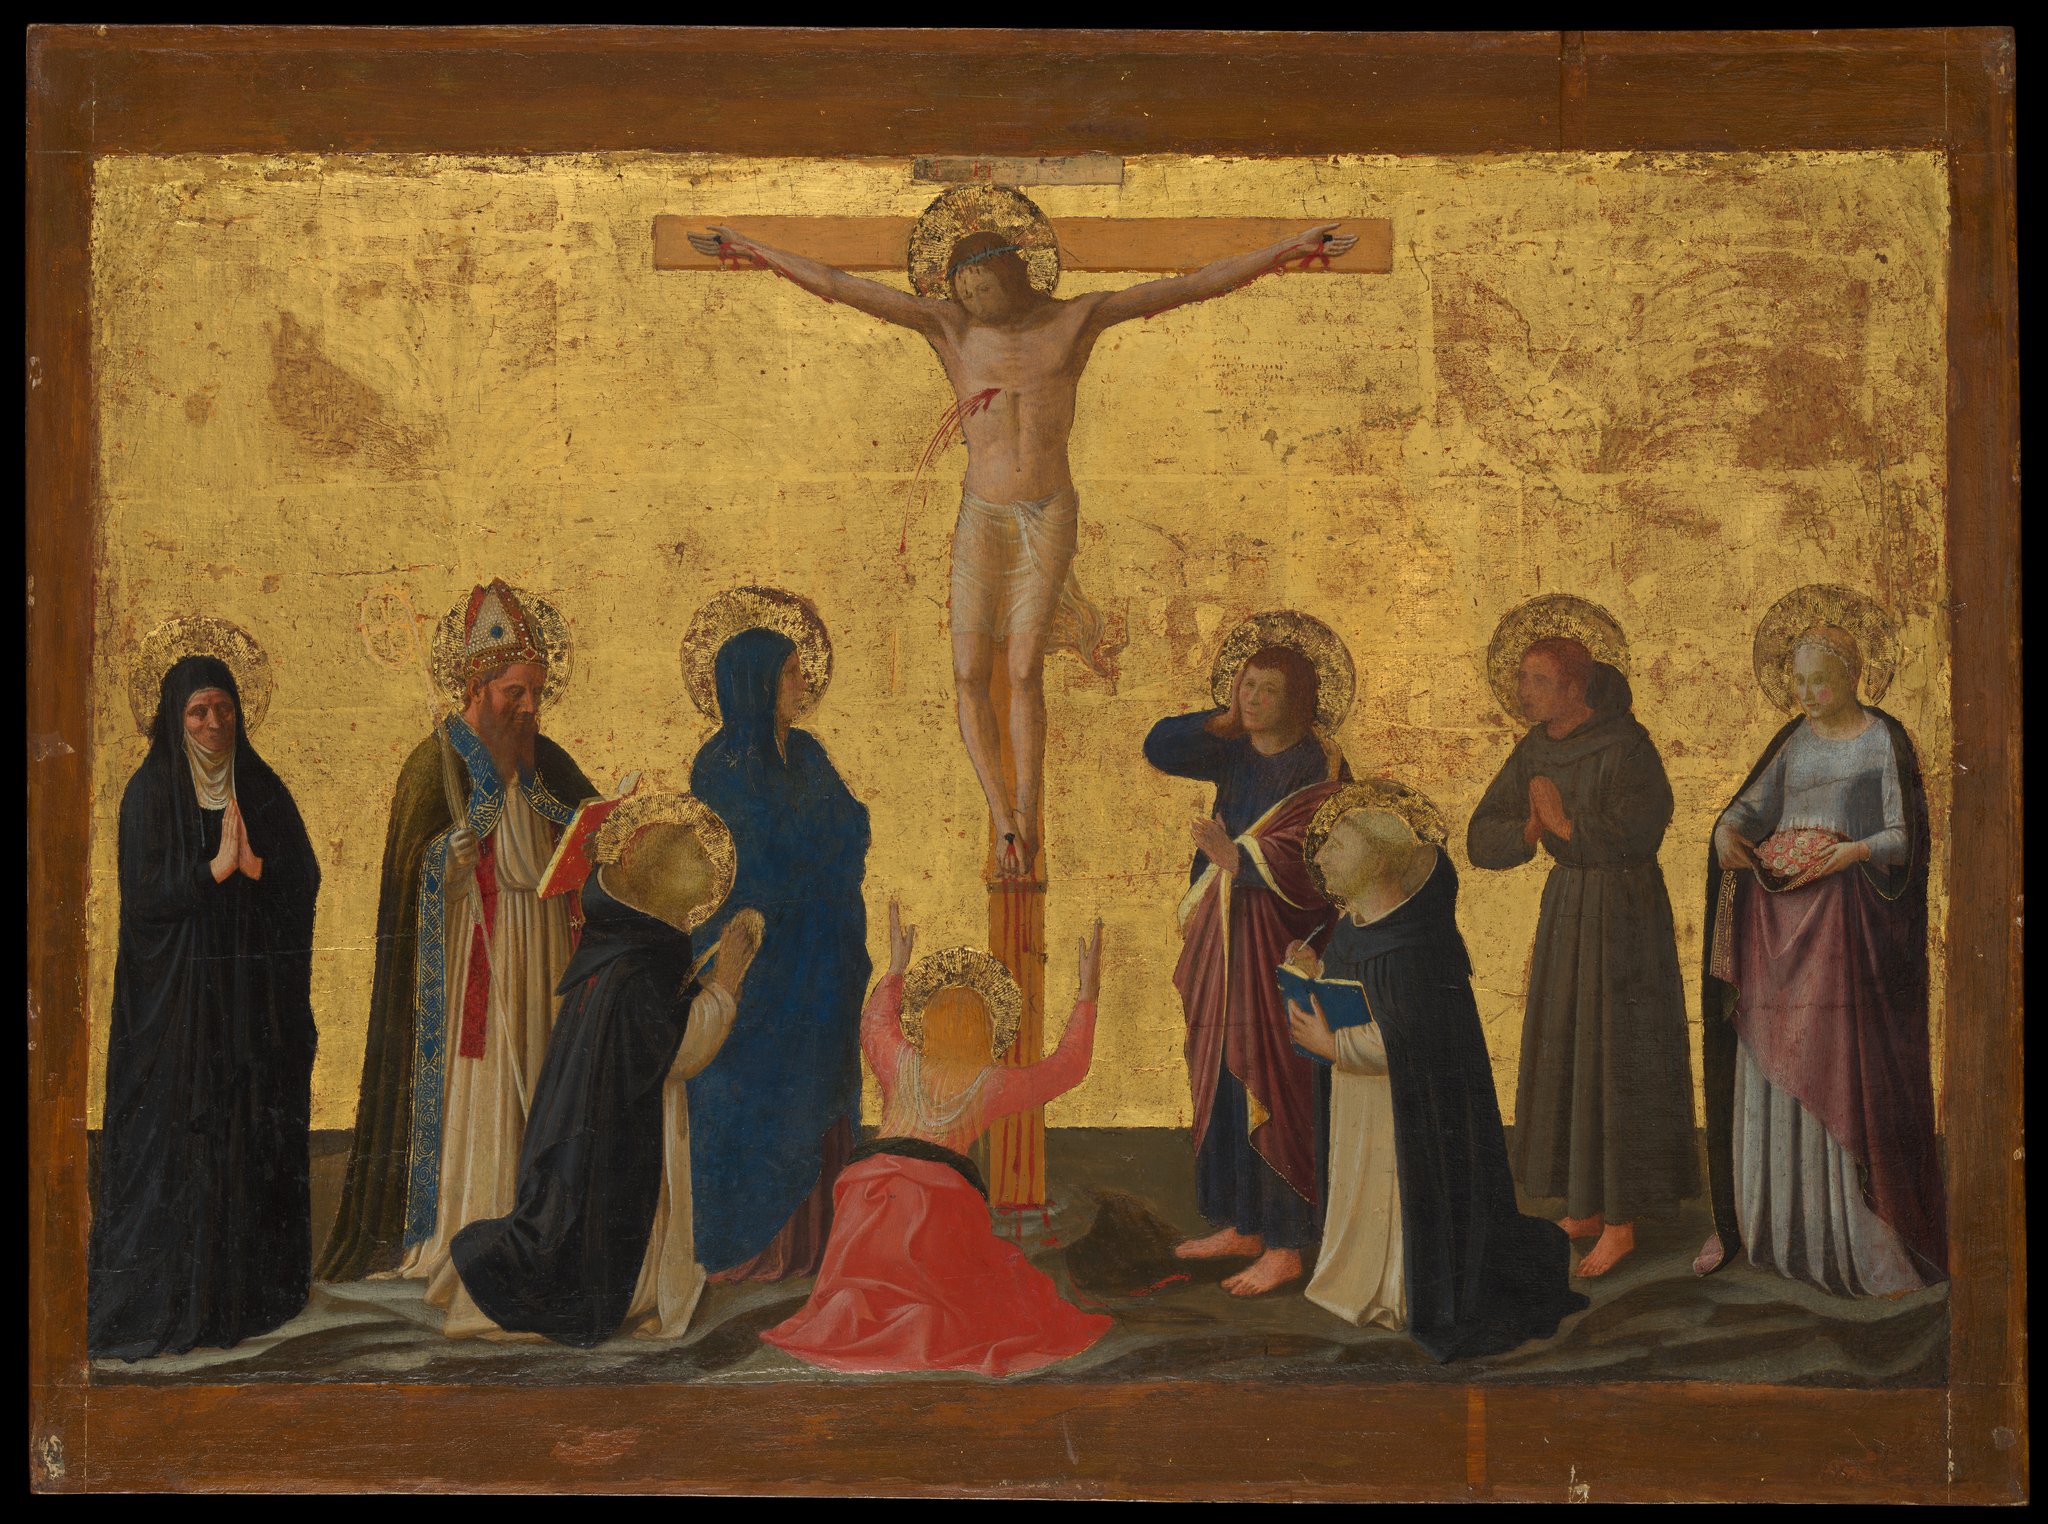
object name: painting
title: The Crucifixion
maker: fra angelico (guido di pietro)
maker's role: artist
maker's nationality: italian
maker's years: 1395-1455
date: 1440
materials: canvas, gold leaf, paint, wood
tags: christ,mary magdalene,saint francis,crucifixion,saints